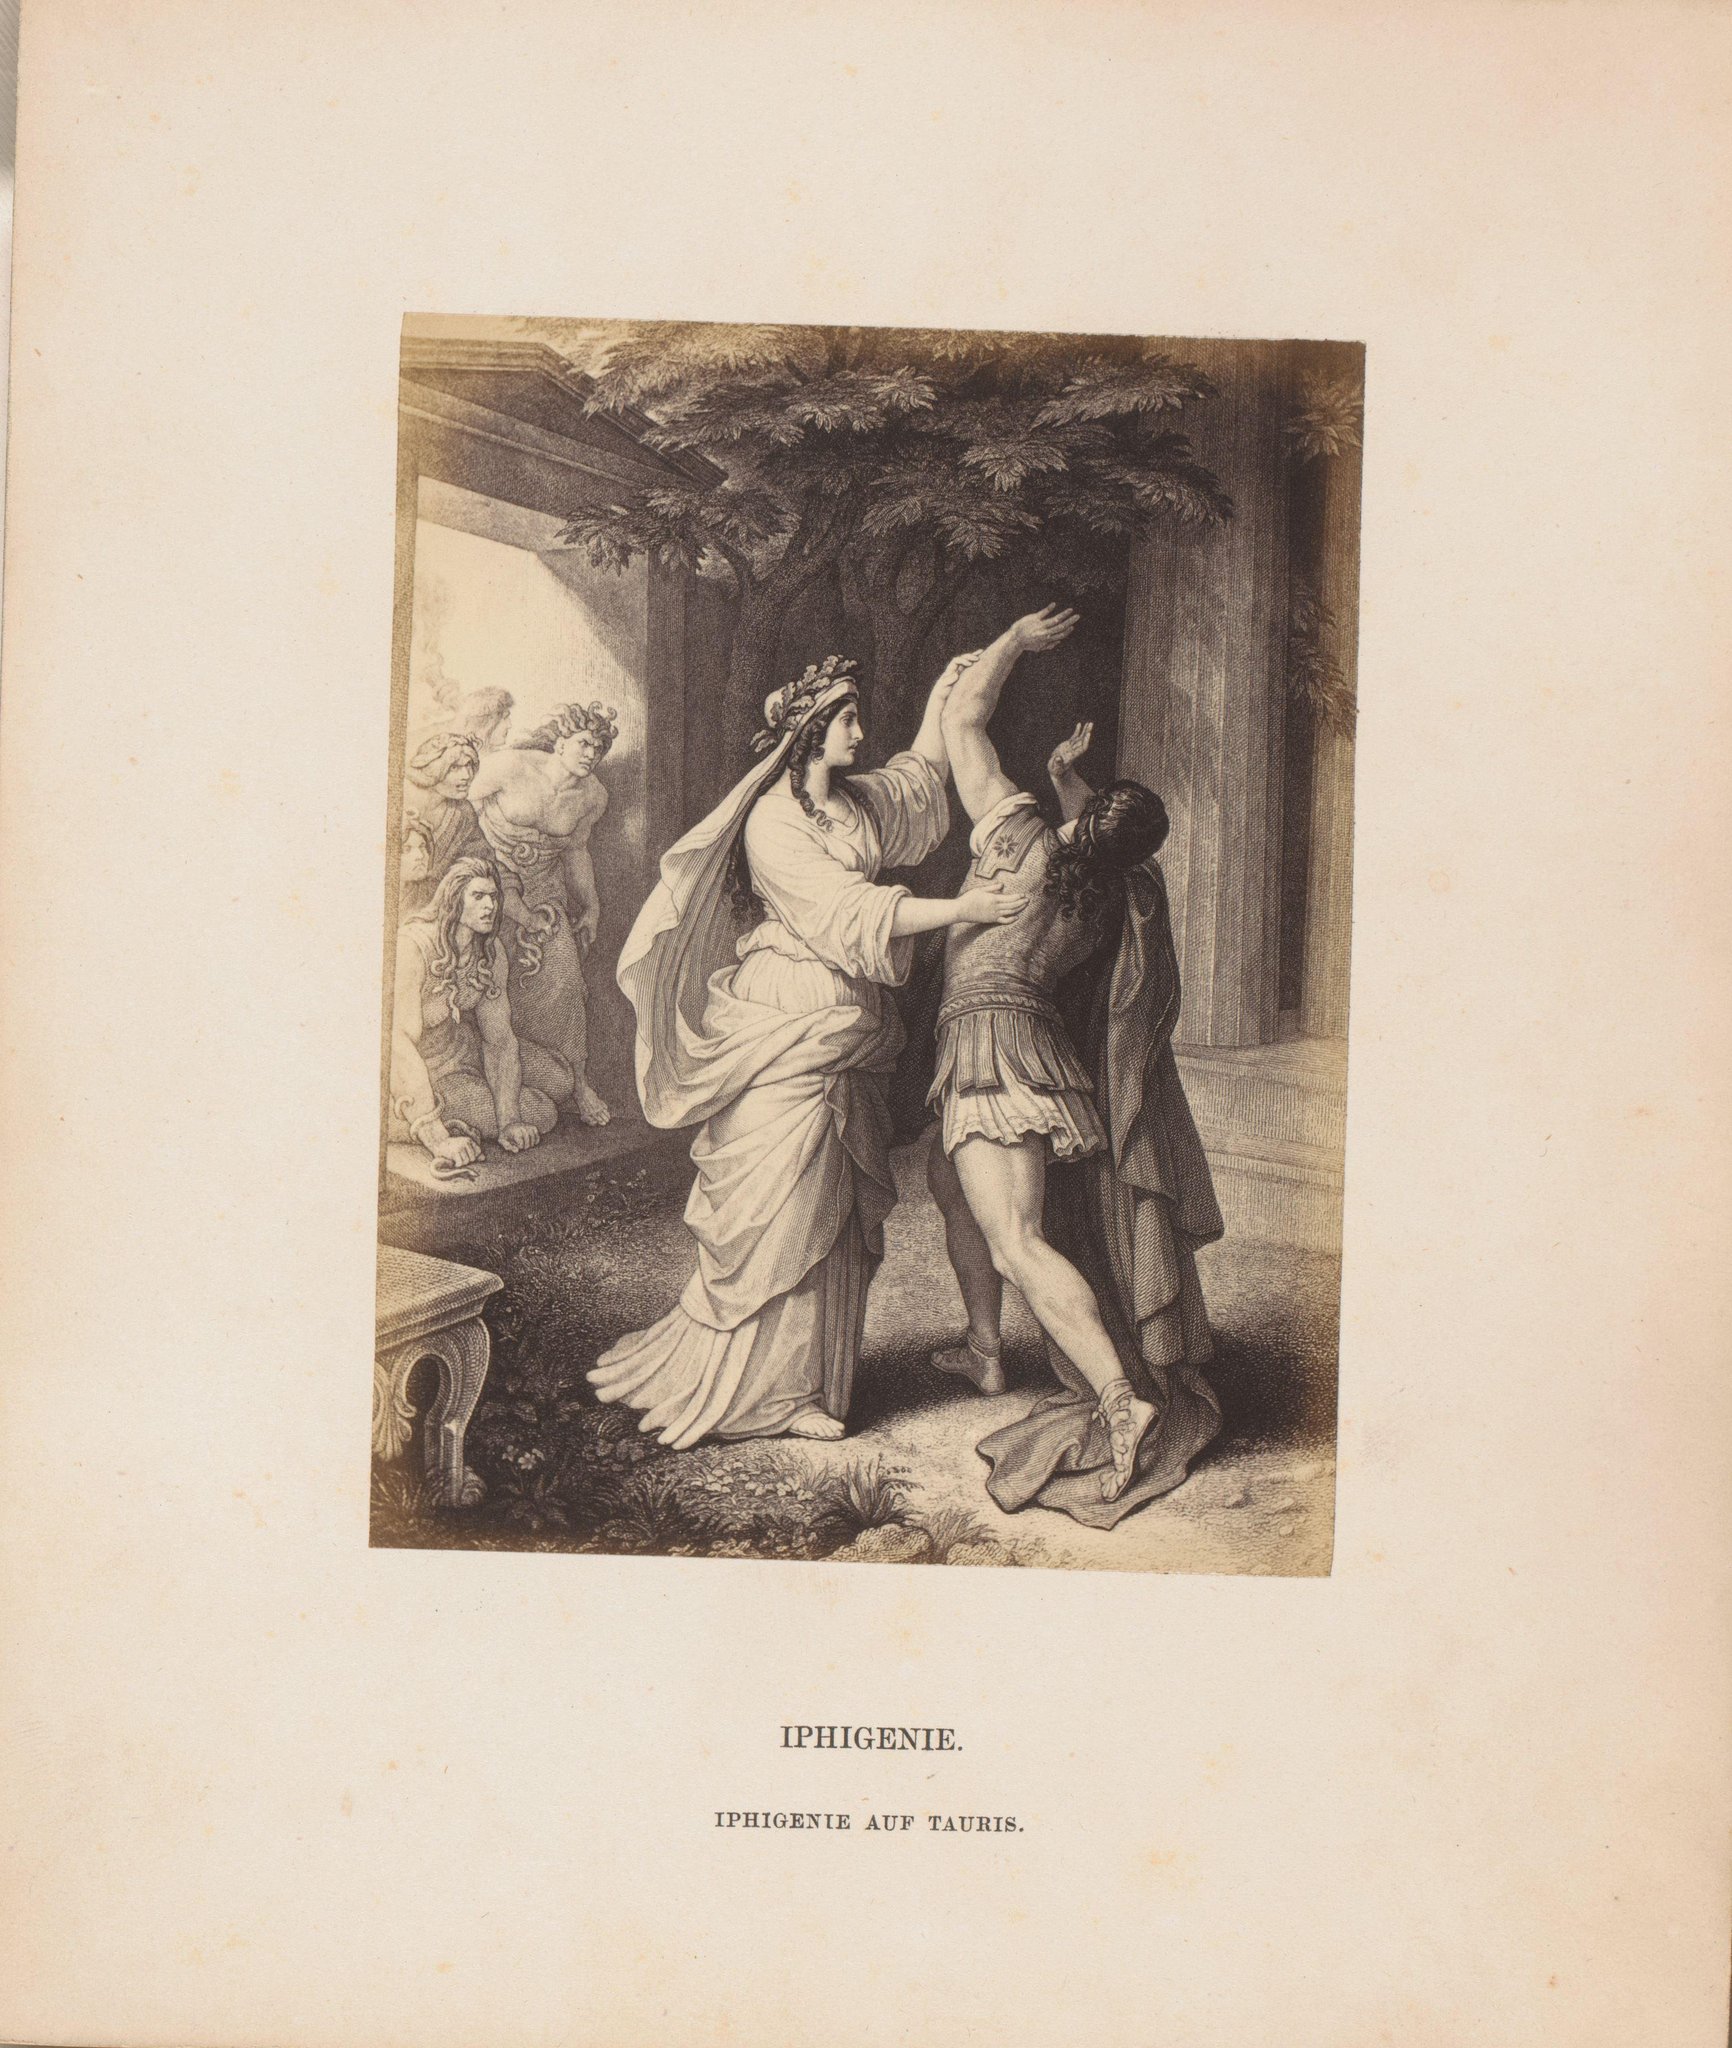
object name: photograph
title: Iphigenie. Iphigenie auf Tauris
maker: Anonymous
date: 1850-1900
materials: cardboard, photographic support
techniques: albumen print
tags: (story of) iphigenia, 95a(orestes) (story of) orestes, brothers or sisters (second degree family relationships), specific works of literature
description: Deze foto maakt deel uit van een omslag met 22 foto's.